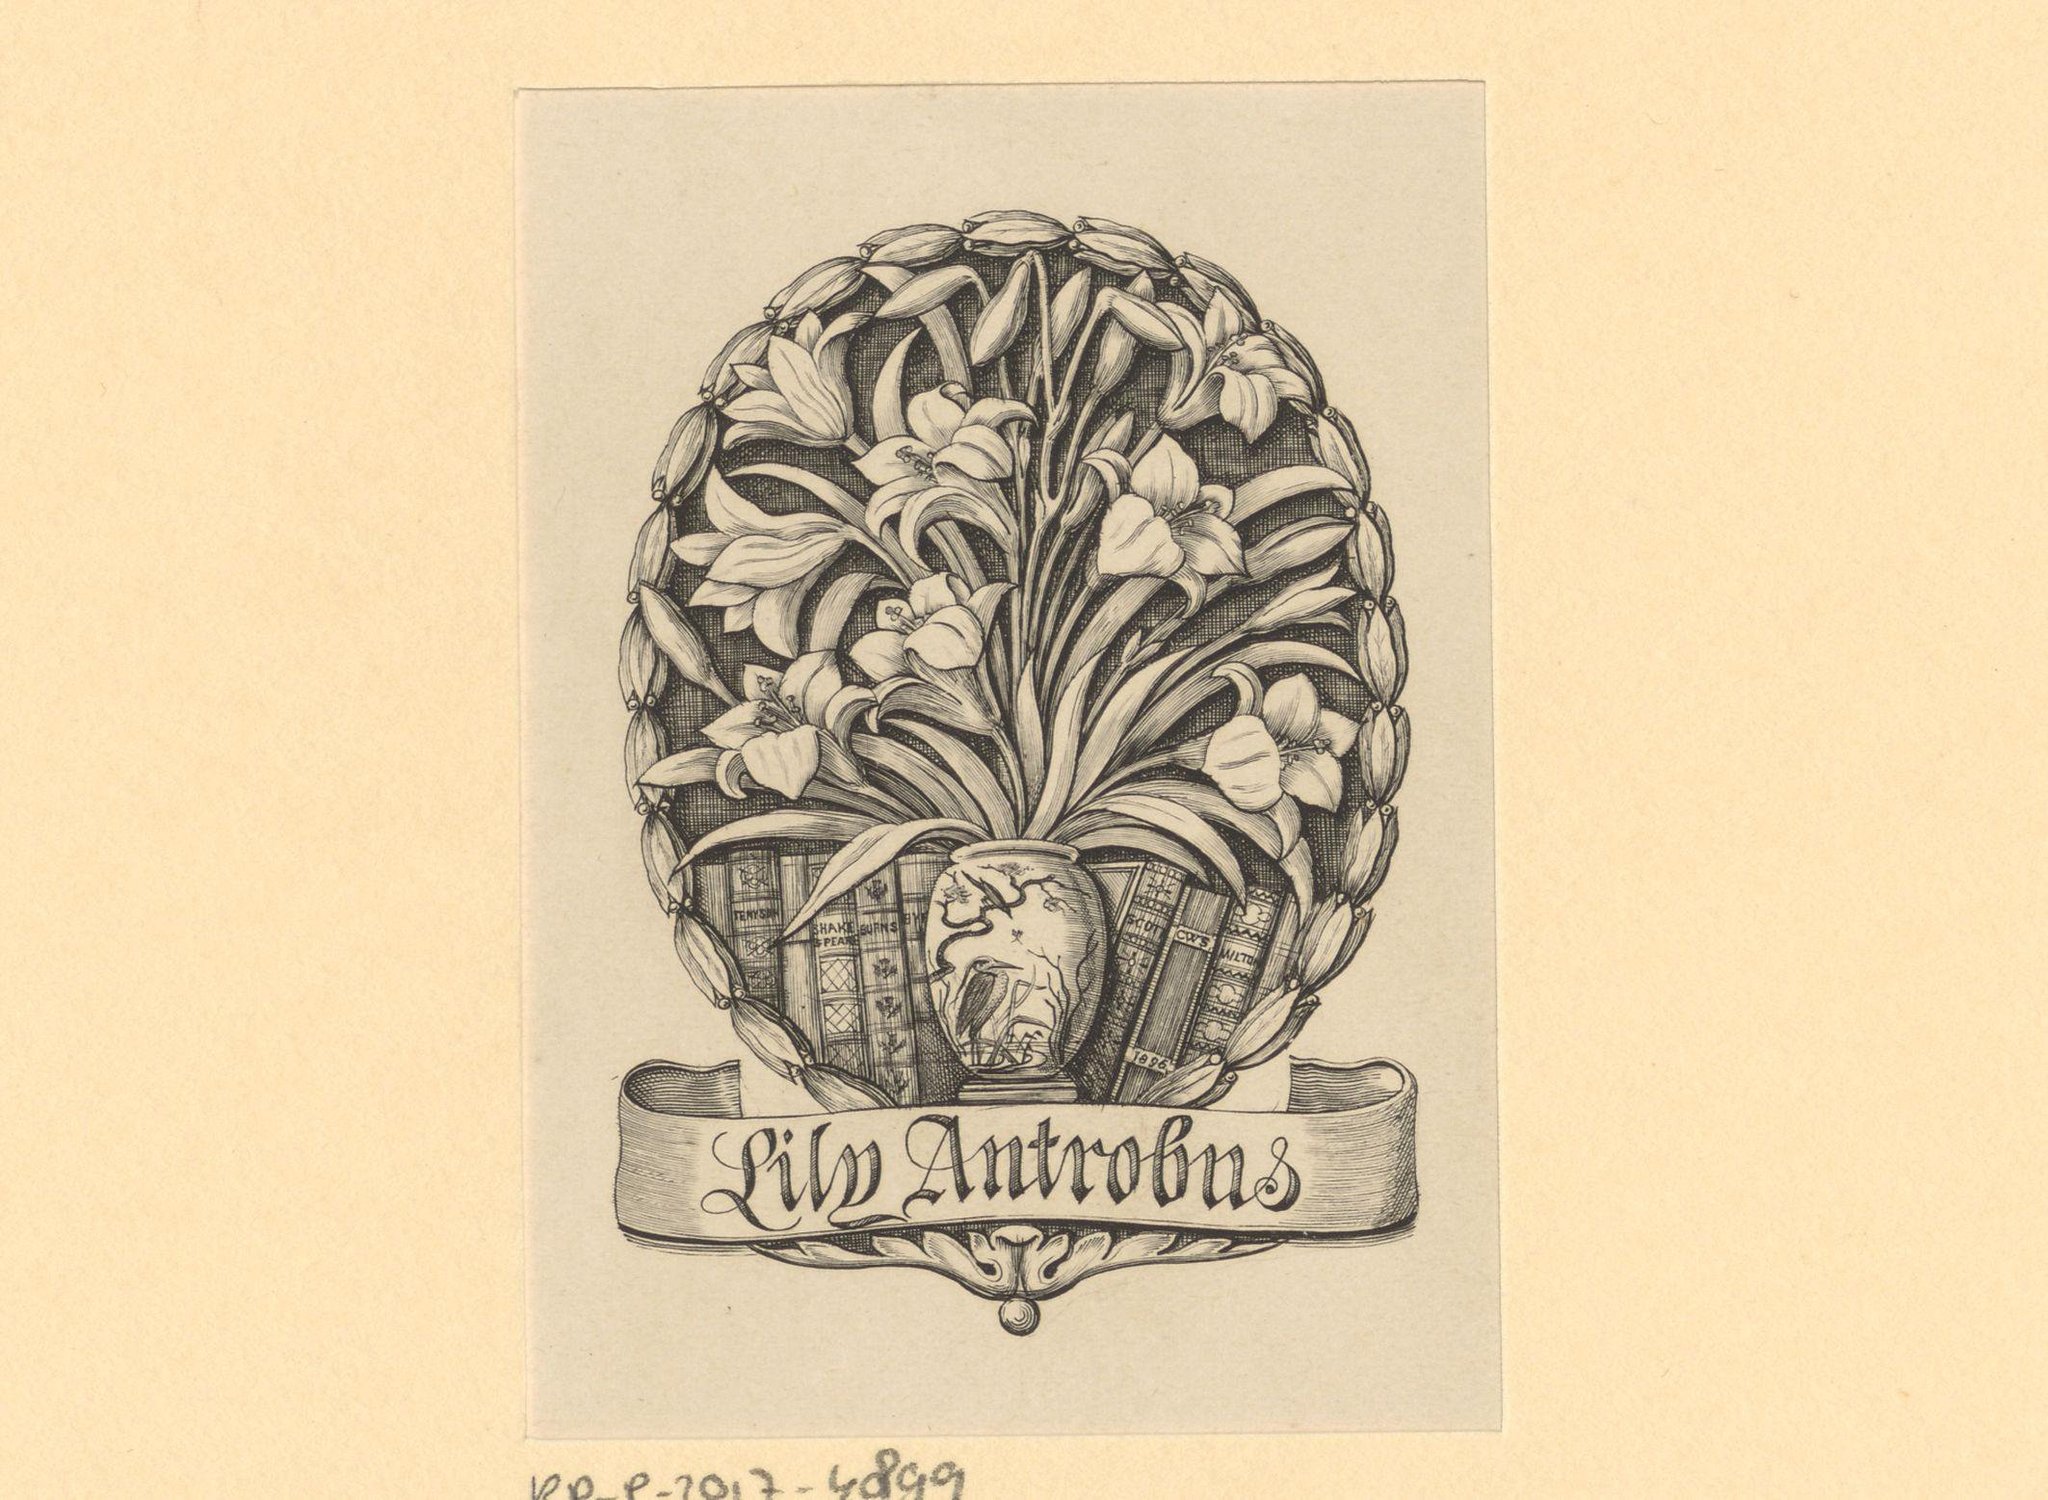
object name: bookplate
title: Ex libris van Lily Antrobus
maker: charles william sherborn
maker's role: print maker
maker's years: 1831-1912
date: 1896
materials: paper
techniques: engraving, etching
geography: england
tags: book, flowers: lily, flowers in a vase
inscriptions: inscription: ‘Sherborn’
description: Het schilderij "Vrouw bij het raam" van Johannes Vermeer was aan het eind van de negentiende eeuw in bezit van Joseph. Het bevindt zich tegenwoordig in The Frick Collection, New York.